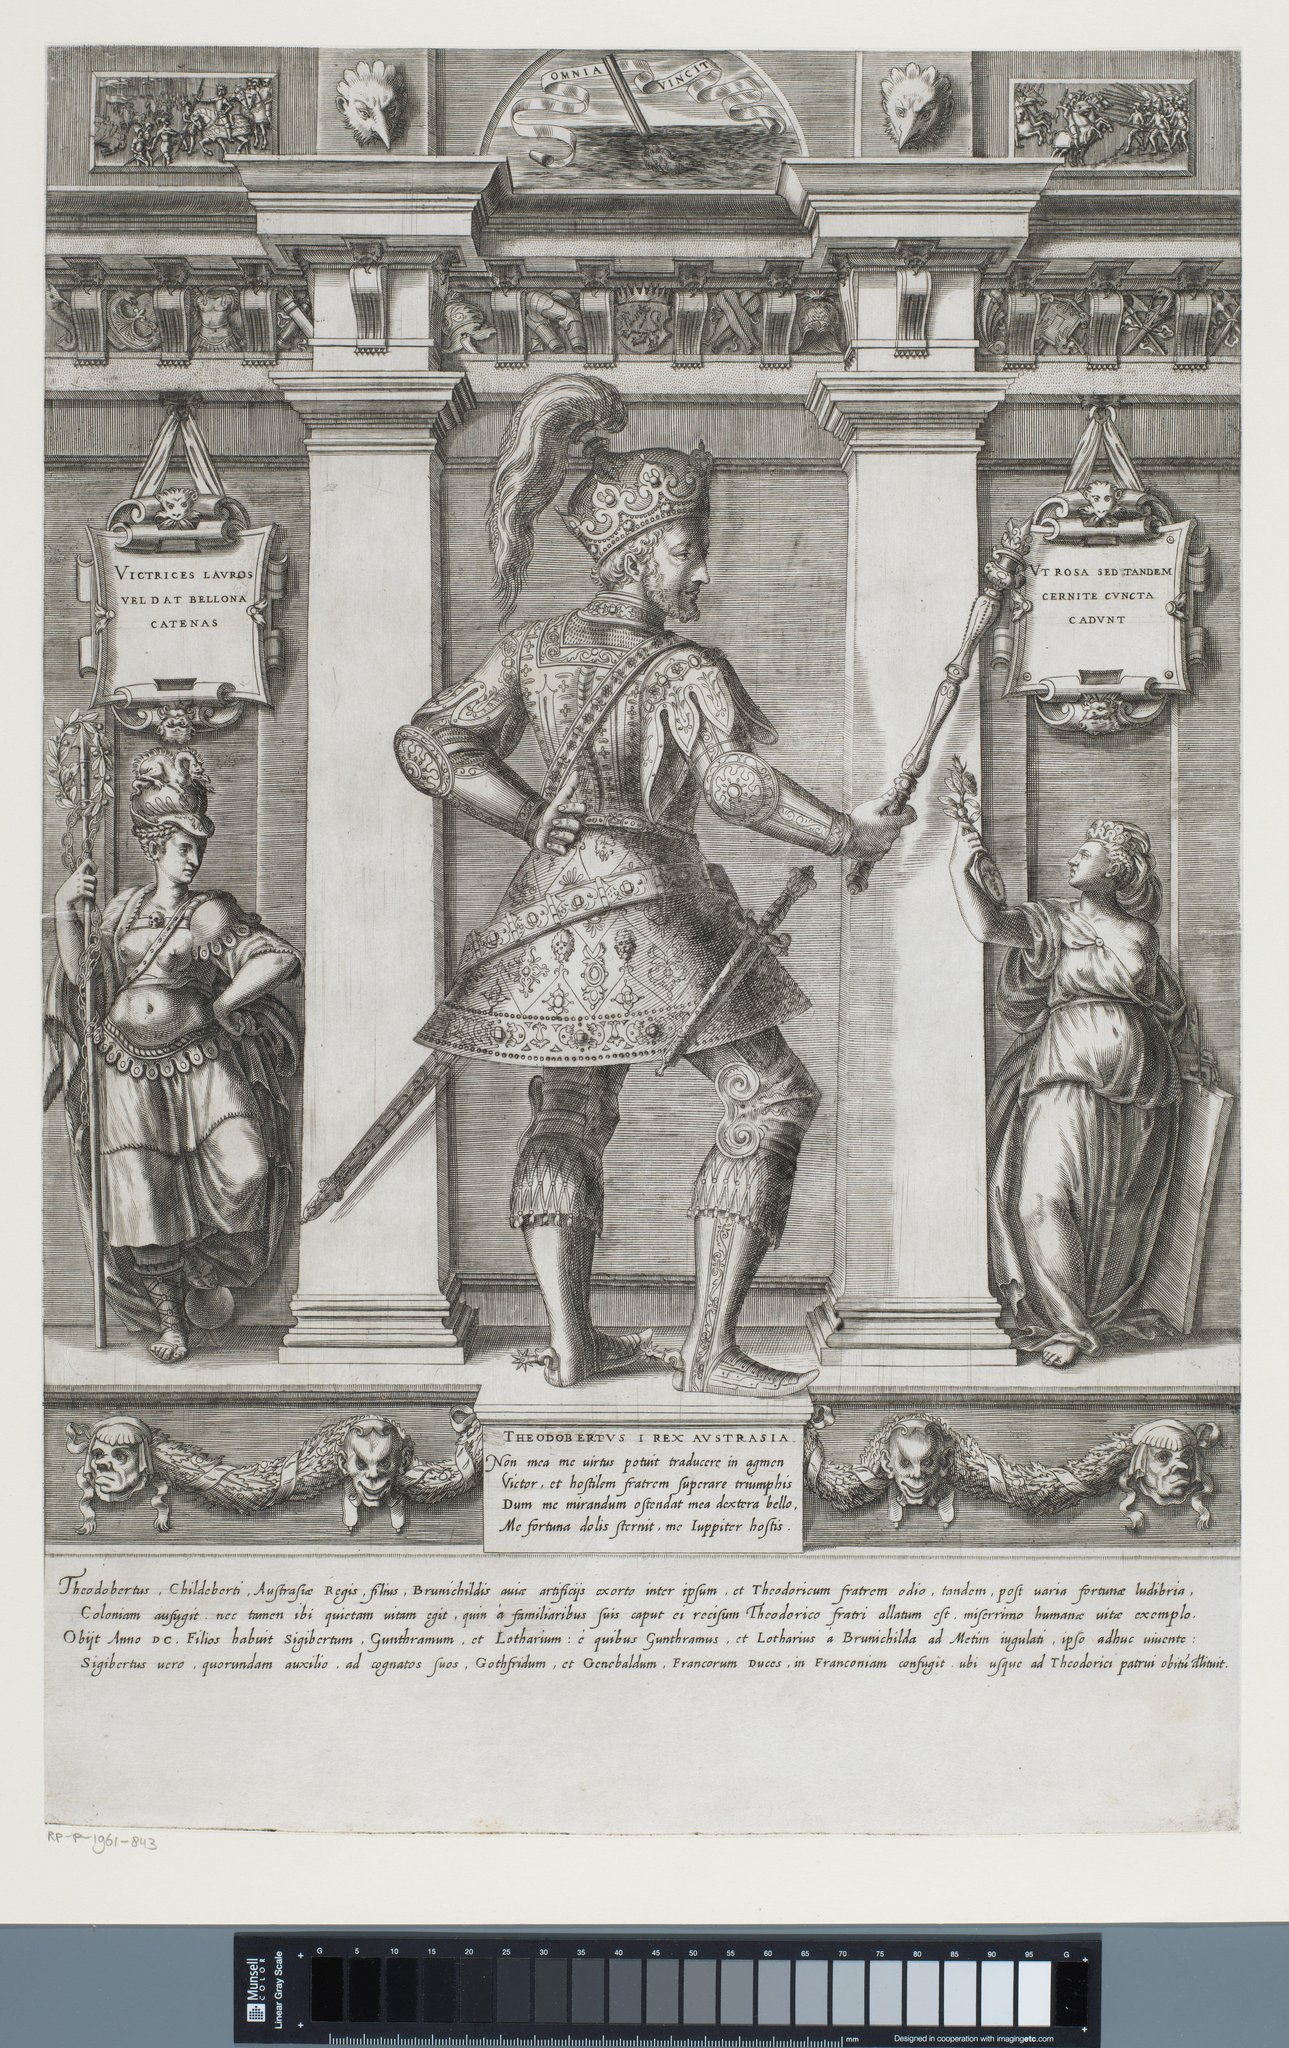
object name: print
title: Portretten van leden van het Oostenrijkse Huis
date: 1569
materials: paper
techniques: engraving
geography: italy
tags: historical persons, ruler, sovereign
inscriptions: collector's mark: Lugt 2228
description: Deze prent maakt deel uit van een reeks van 58 prenten. Het meerendeel van de prenten bevat portretten van 74 leden van het Oostenrijkse Huis, naar tekeningen door Francesco Terzio, die deels getekend zijn naar de 28 levensgrote bronzen beelden die rond de cenotaaf van Maximiliaan I in de Hofkirche te Innsbruck staan.